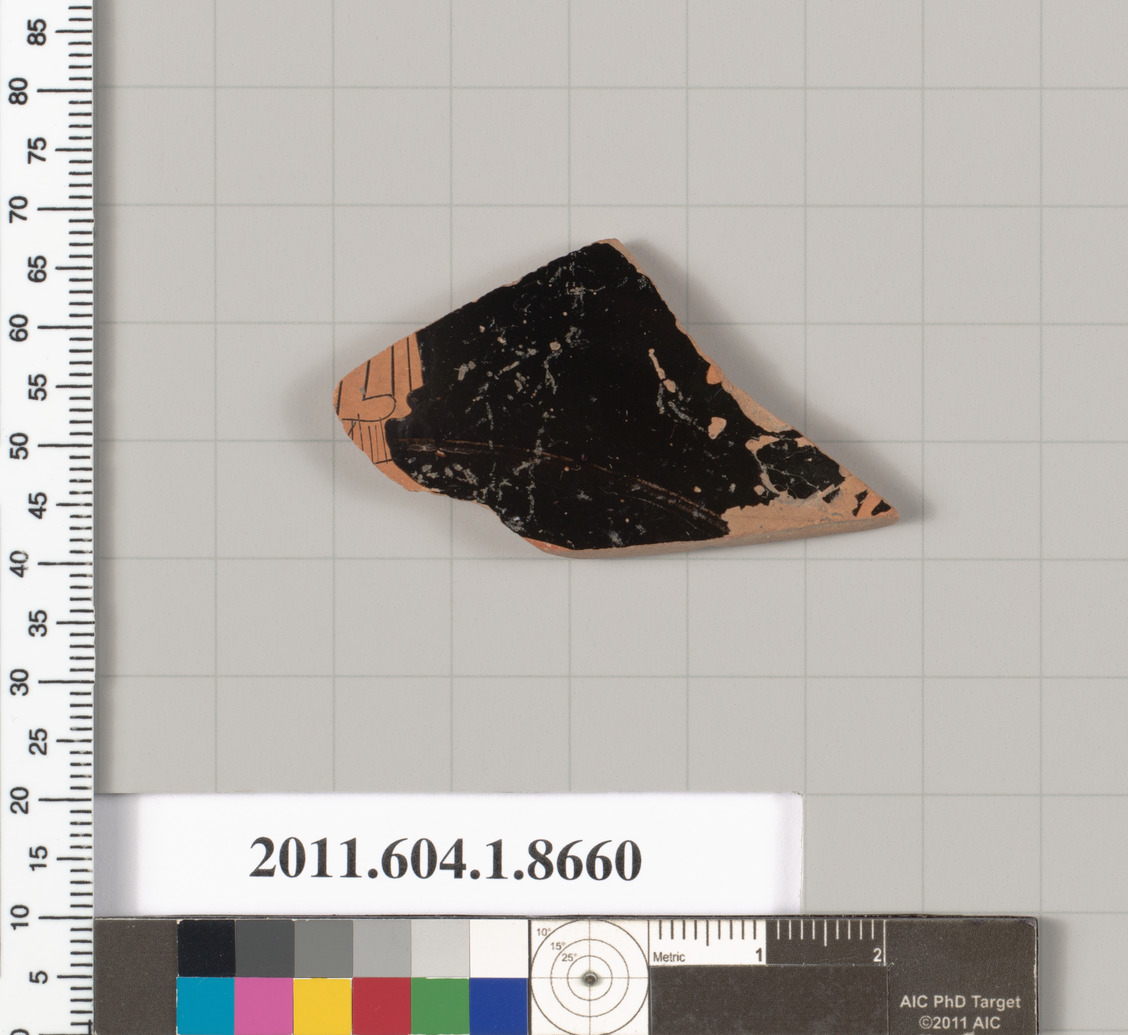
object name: kylix fragment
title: Terracotta fragment of a stemless kylix (drinking cup)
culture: greek, attic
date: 460-450 BCE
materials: terracotta